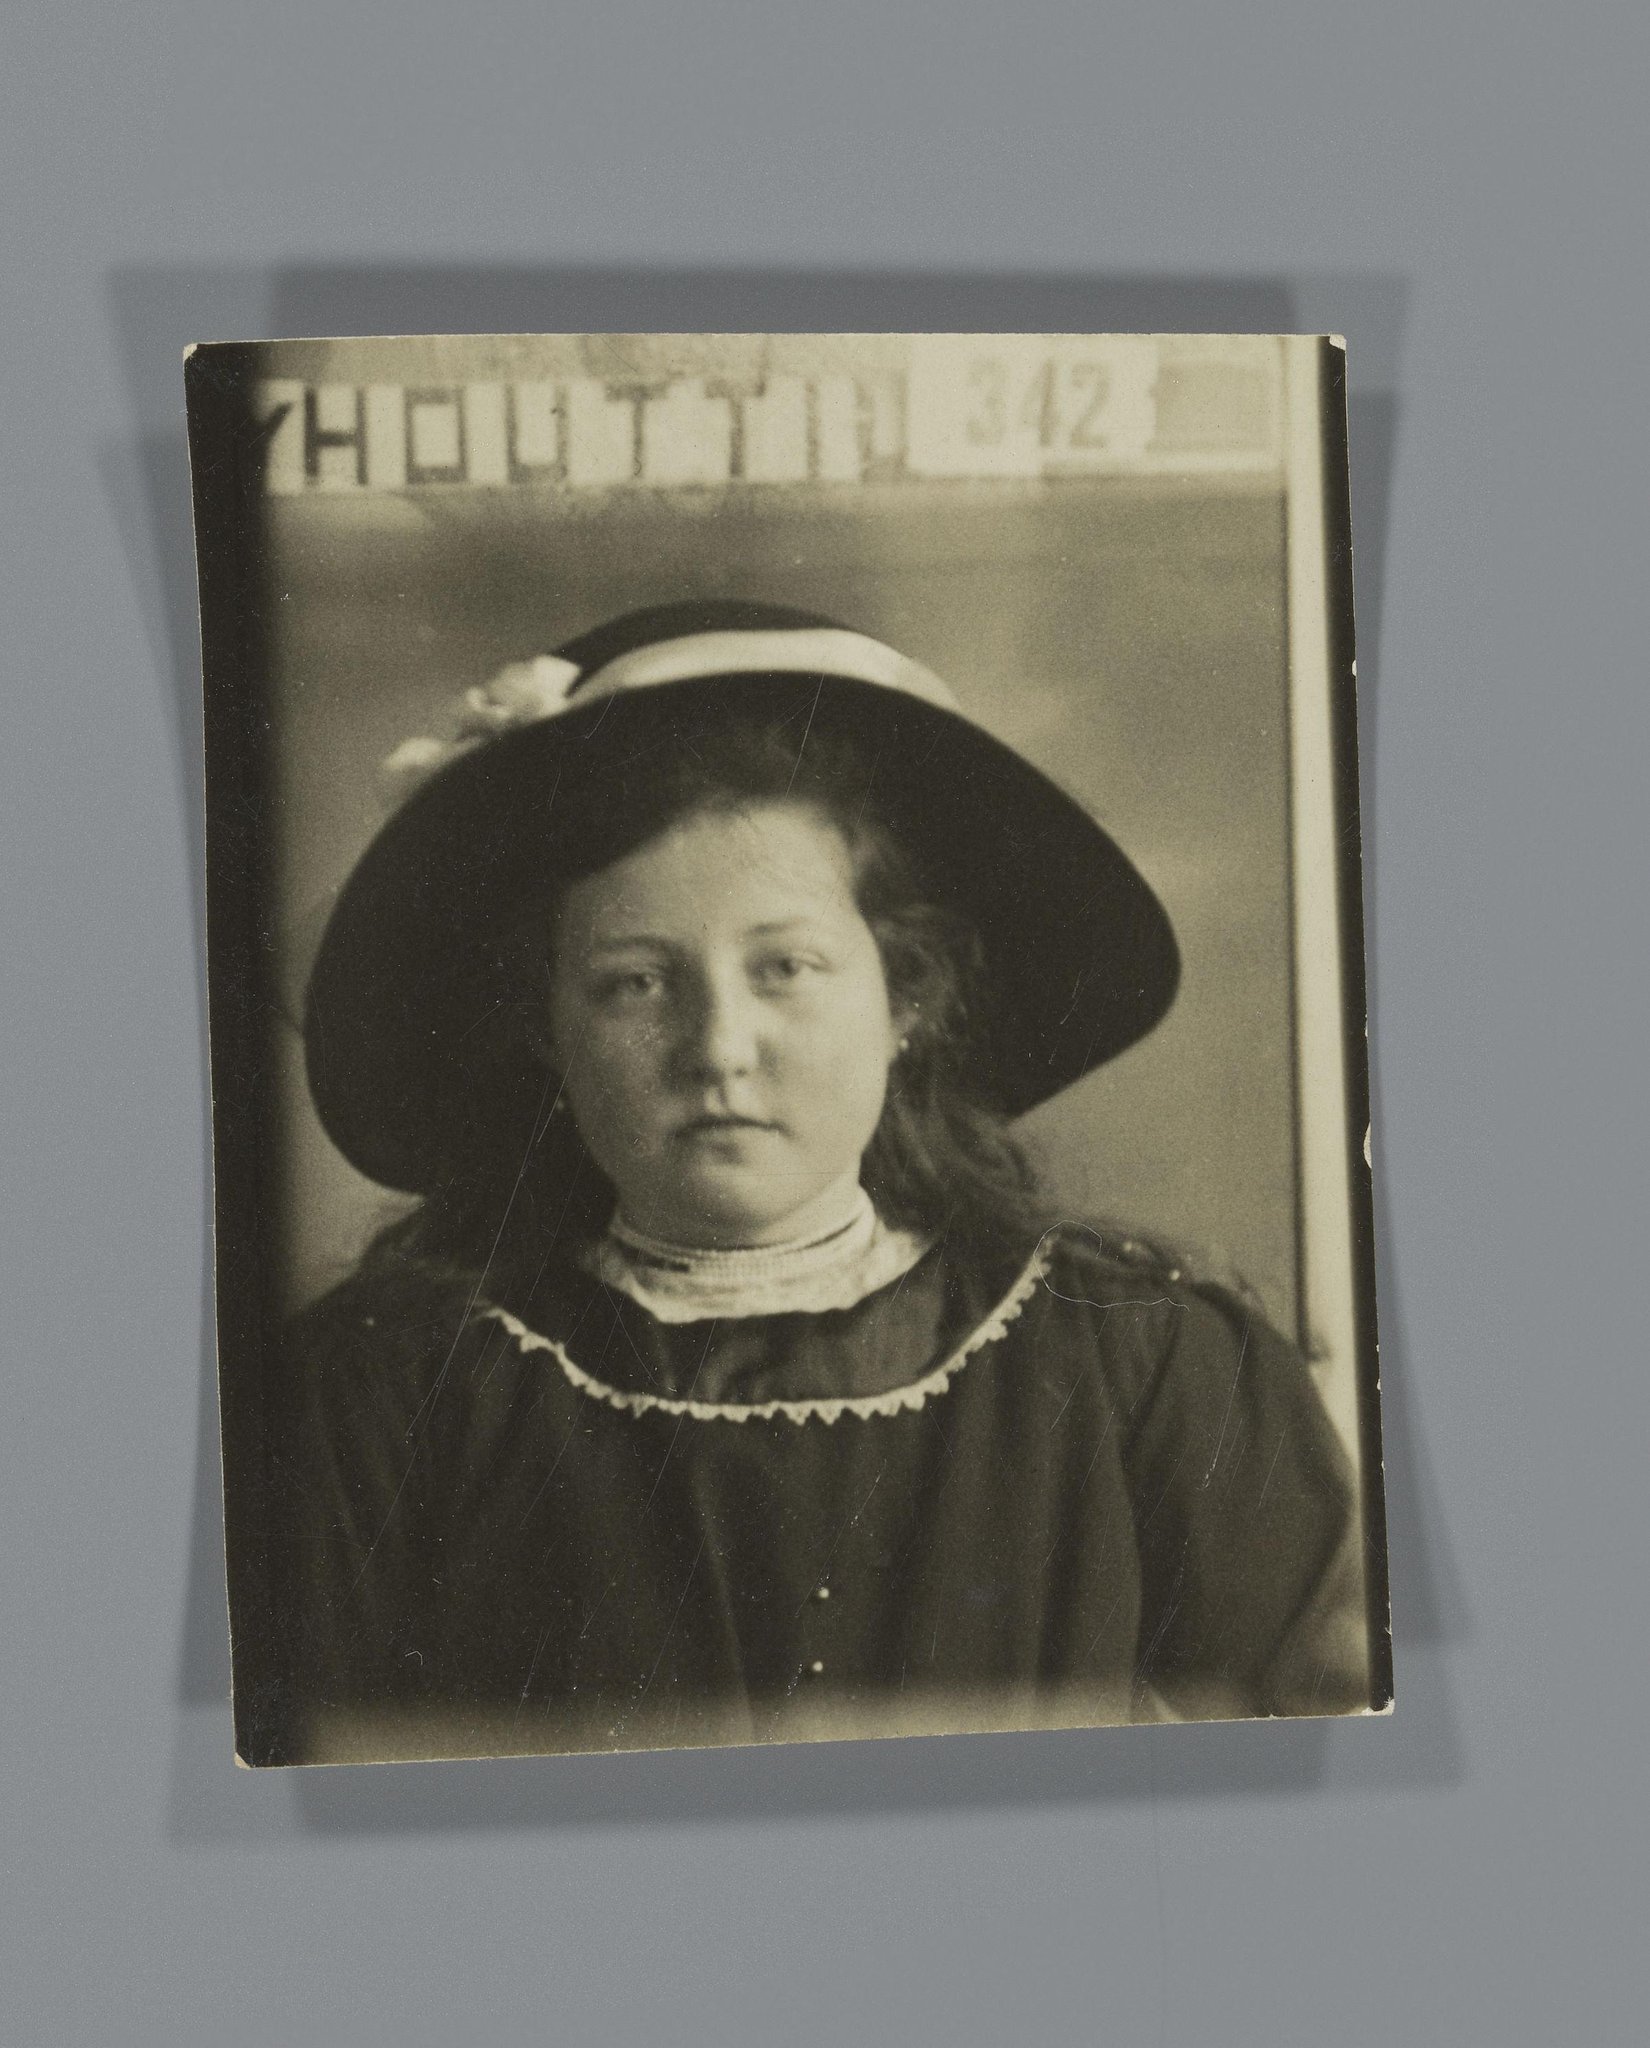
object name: snapshot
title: Rapid photographs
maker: jan gottfried stütner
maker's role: fotograaf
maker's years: 1892-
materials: photographic support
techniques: gelatin silver print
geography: alkmaar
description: Between 1912 and 1930, anyone could have their portrait taken at the many so-called rapid photography studios in the shopping streets of mainly (medium) large-size European cities. As if on an assembly line, the youngest clerk shot the photographs with a special camera and in artificial light and developed them. Later in the day, the customer collected a sheet with 12 portrait photos for 25 cents. This form of photographic mass production gave rise to a fascinating tableau of boys, girls, men and women not previously seen in photographs; candid and informal. There were at least 150 quick-photo studios, from Alkmaar to Zutphen. Many called themselves ‘American,’ mistakenly as it turns out because hardly any examples from that country have been found.